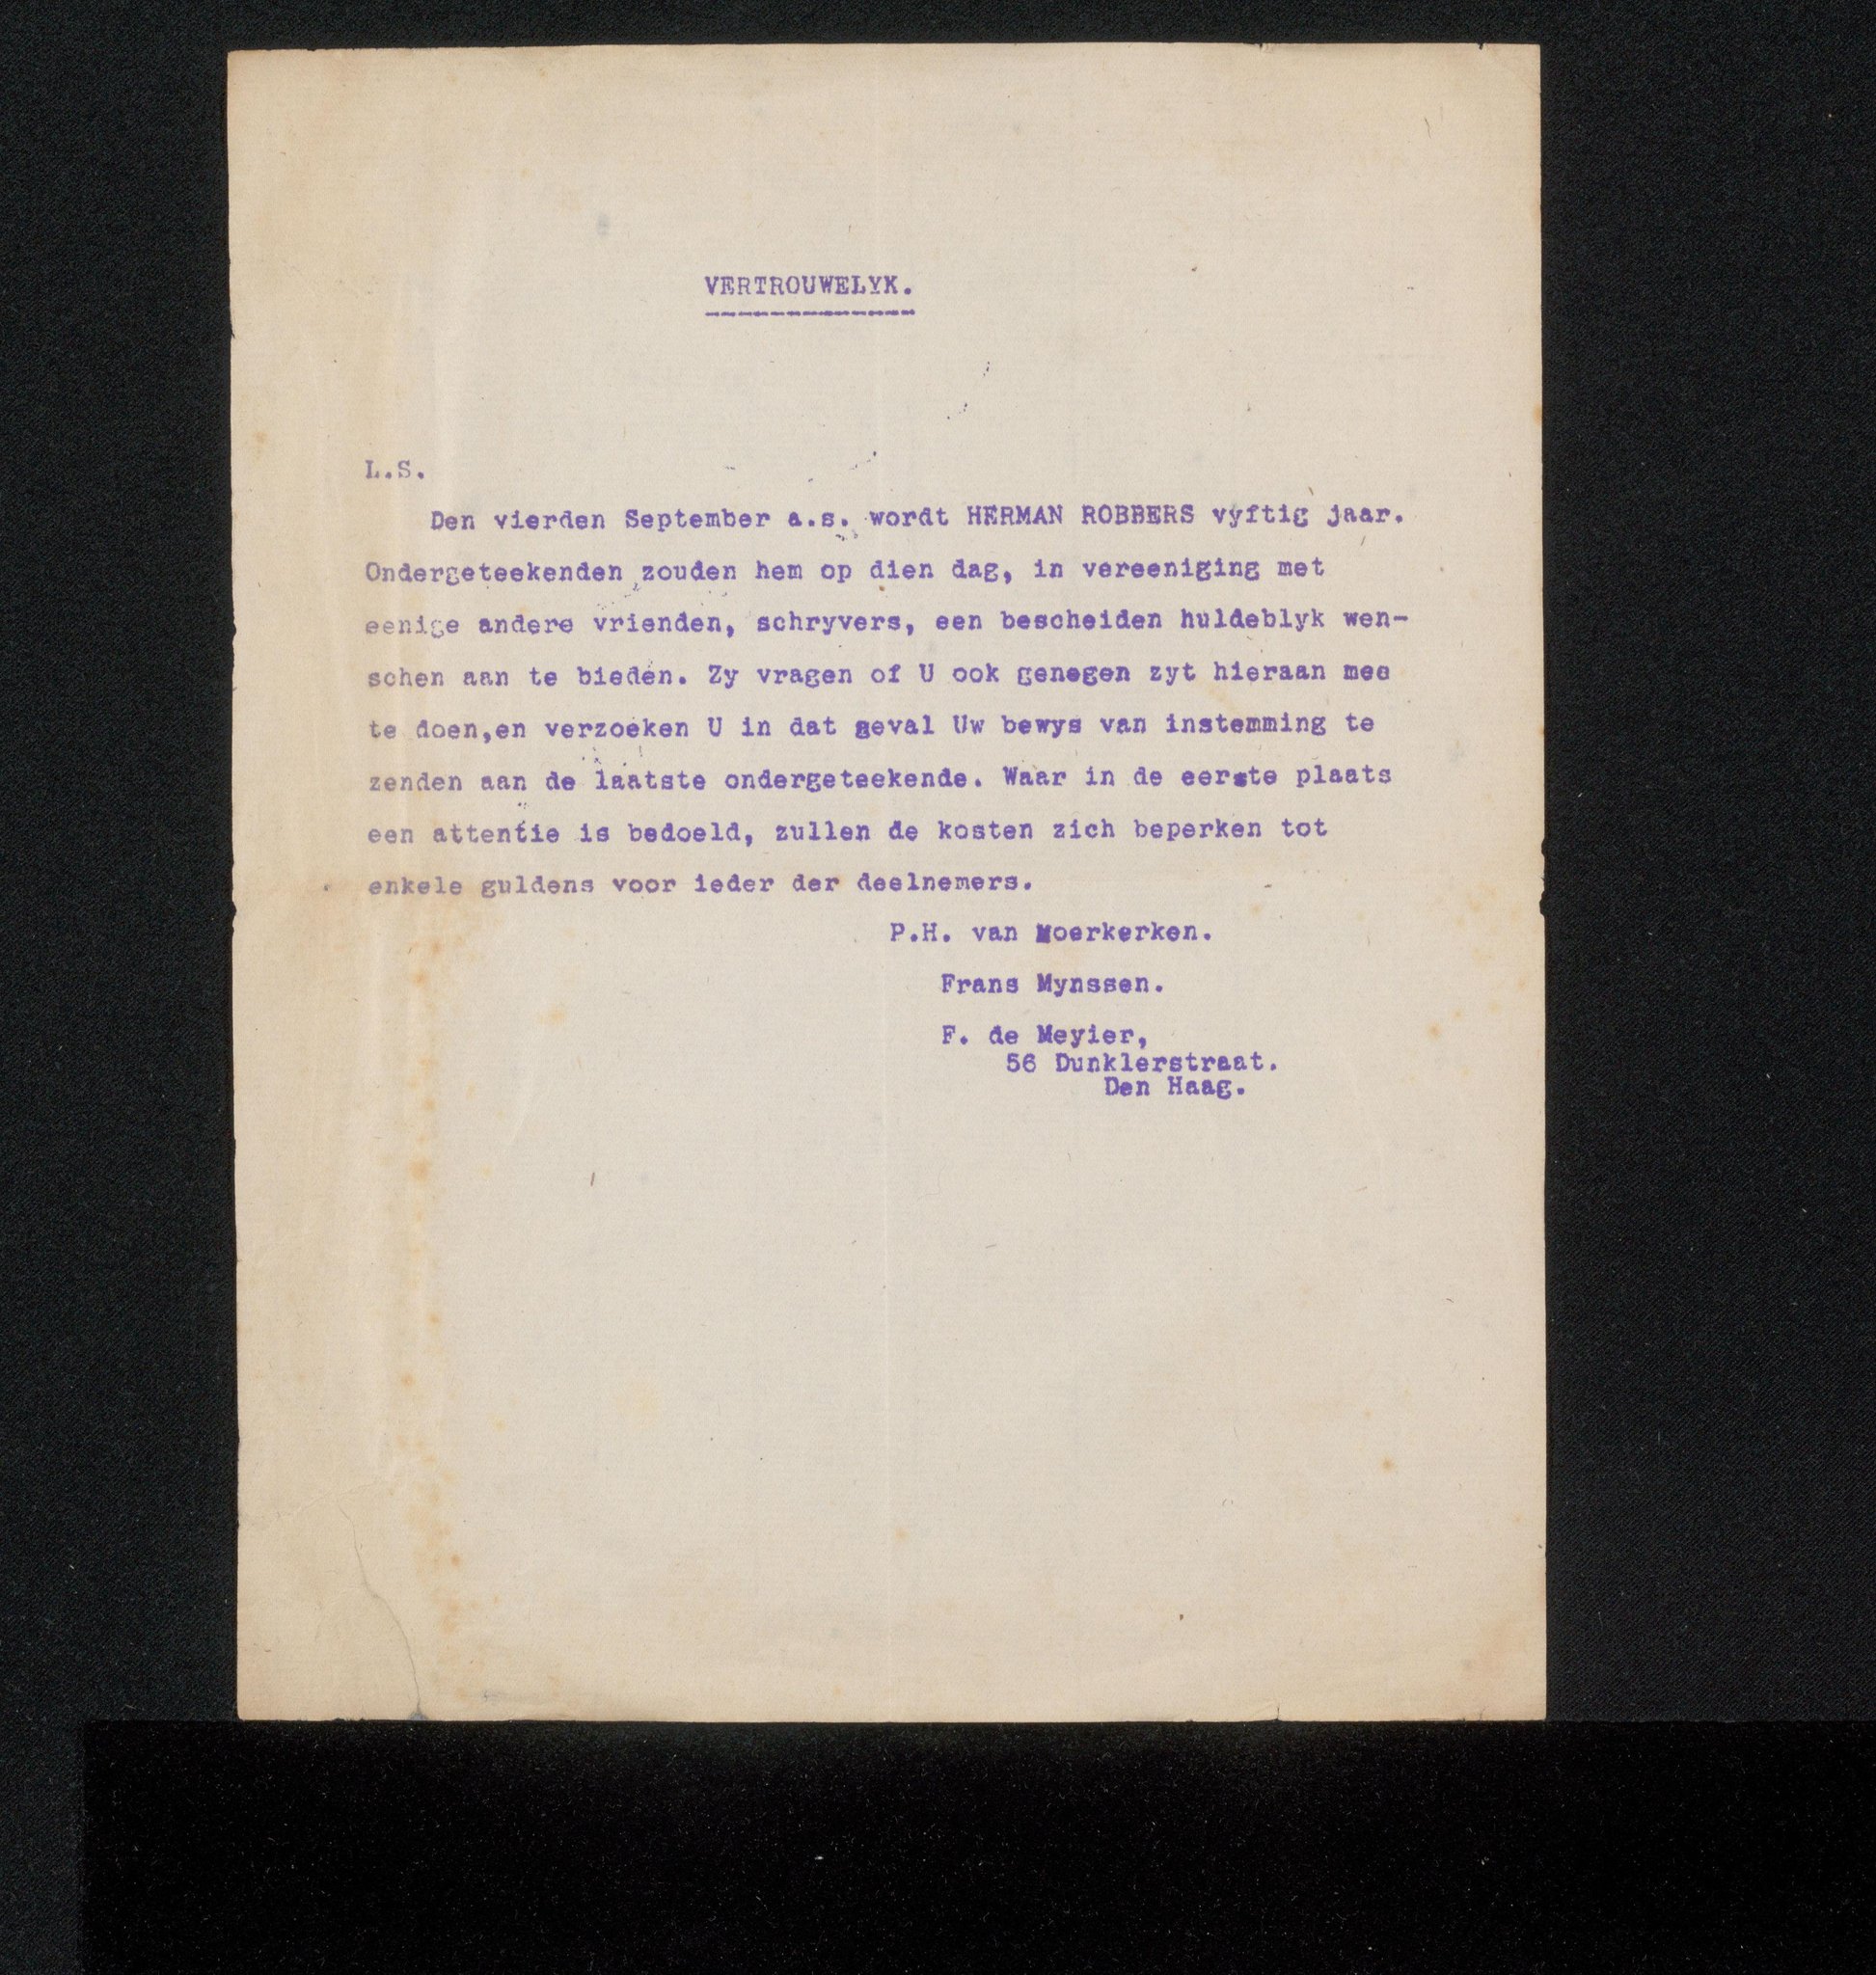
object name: letter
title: Brief aan Philip Zilcken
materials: ink, paper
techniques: typewriting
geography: the hague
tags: rotterdam, amsterdam, herman robbers, painter, draughtsman, philip zilcken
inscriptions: collector's mark: ‘RPK’